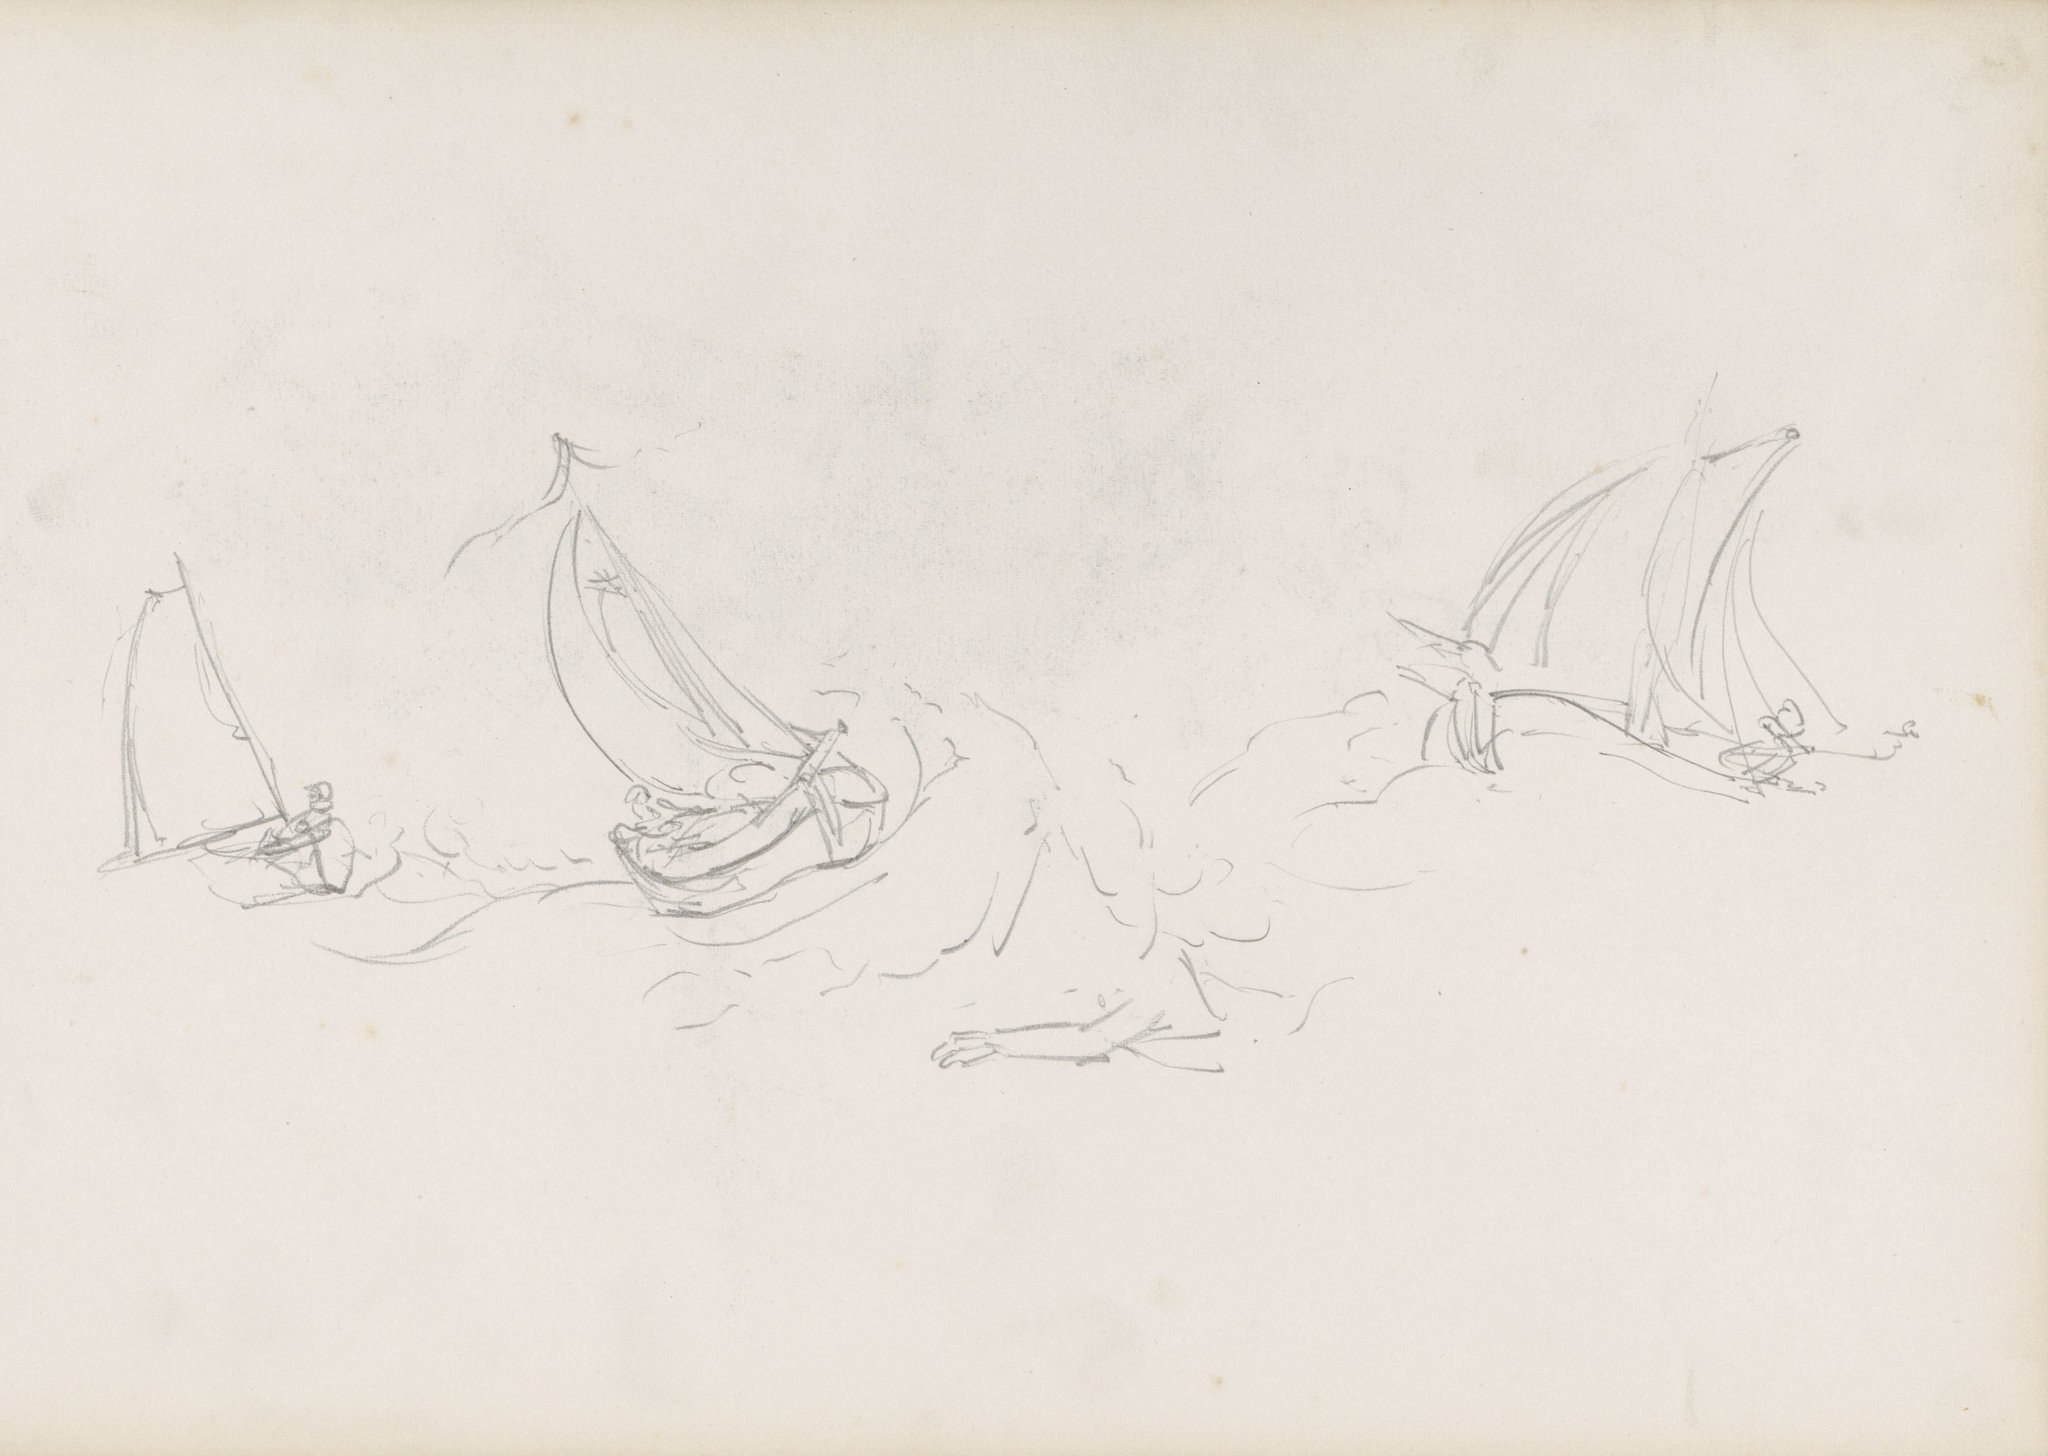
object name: drawing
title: Zeilschepen op een onstuimige zee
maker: george hendrik breitner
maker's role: draughtsman, painter, print maker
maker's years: 1857-1923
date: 1873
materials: paper, pencil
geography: rotterdam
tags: sailing-ship, sailing-boat, storm at sea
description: Deze tekening heeft oorspronkelijk als blad 30 deel uitgemaakt van een schetsboek. Zie voor dit schetsboek het gerelateerd object.